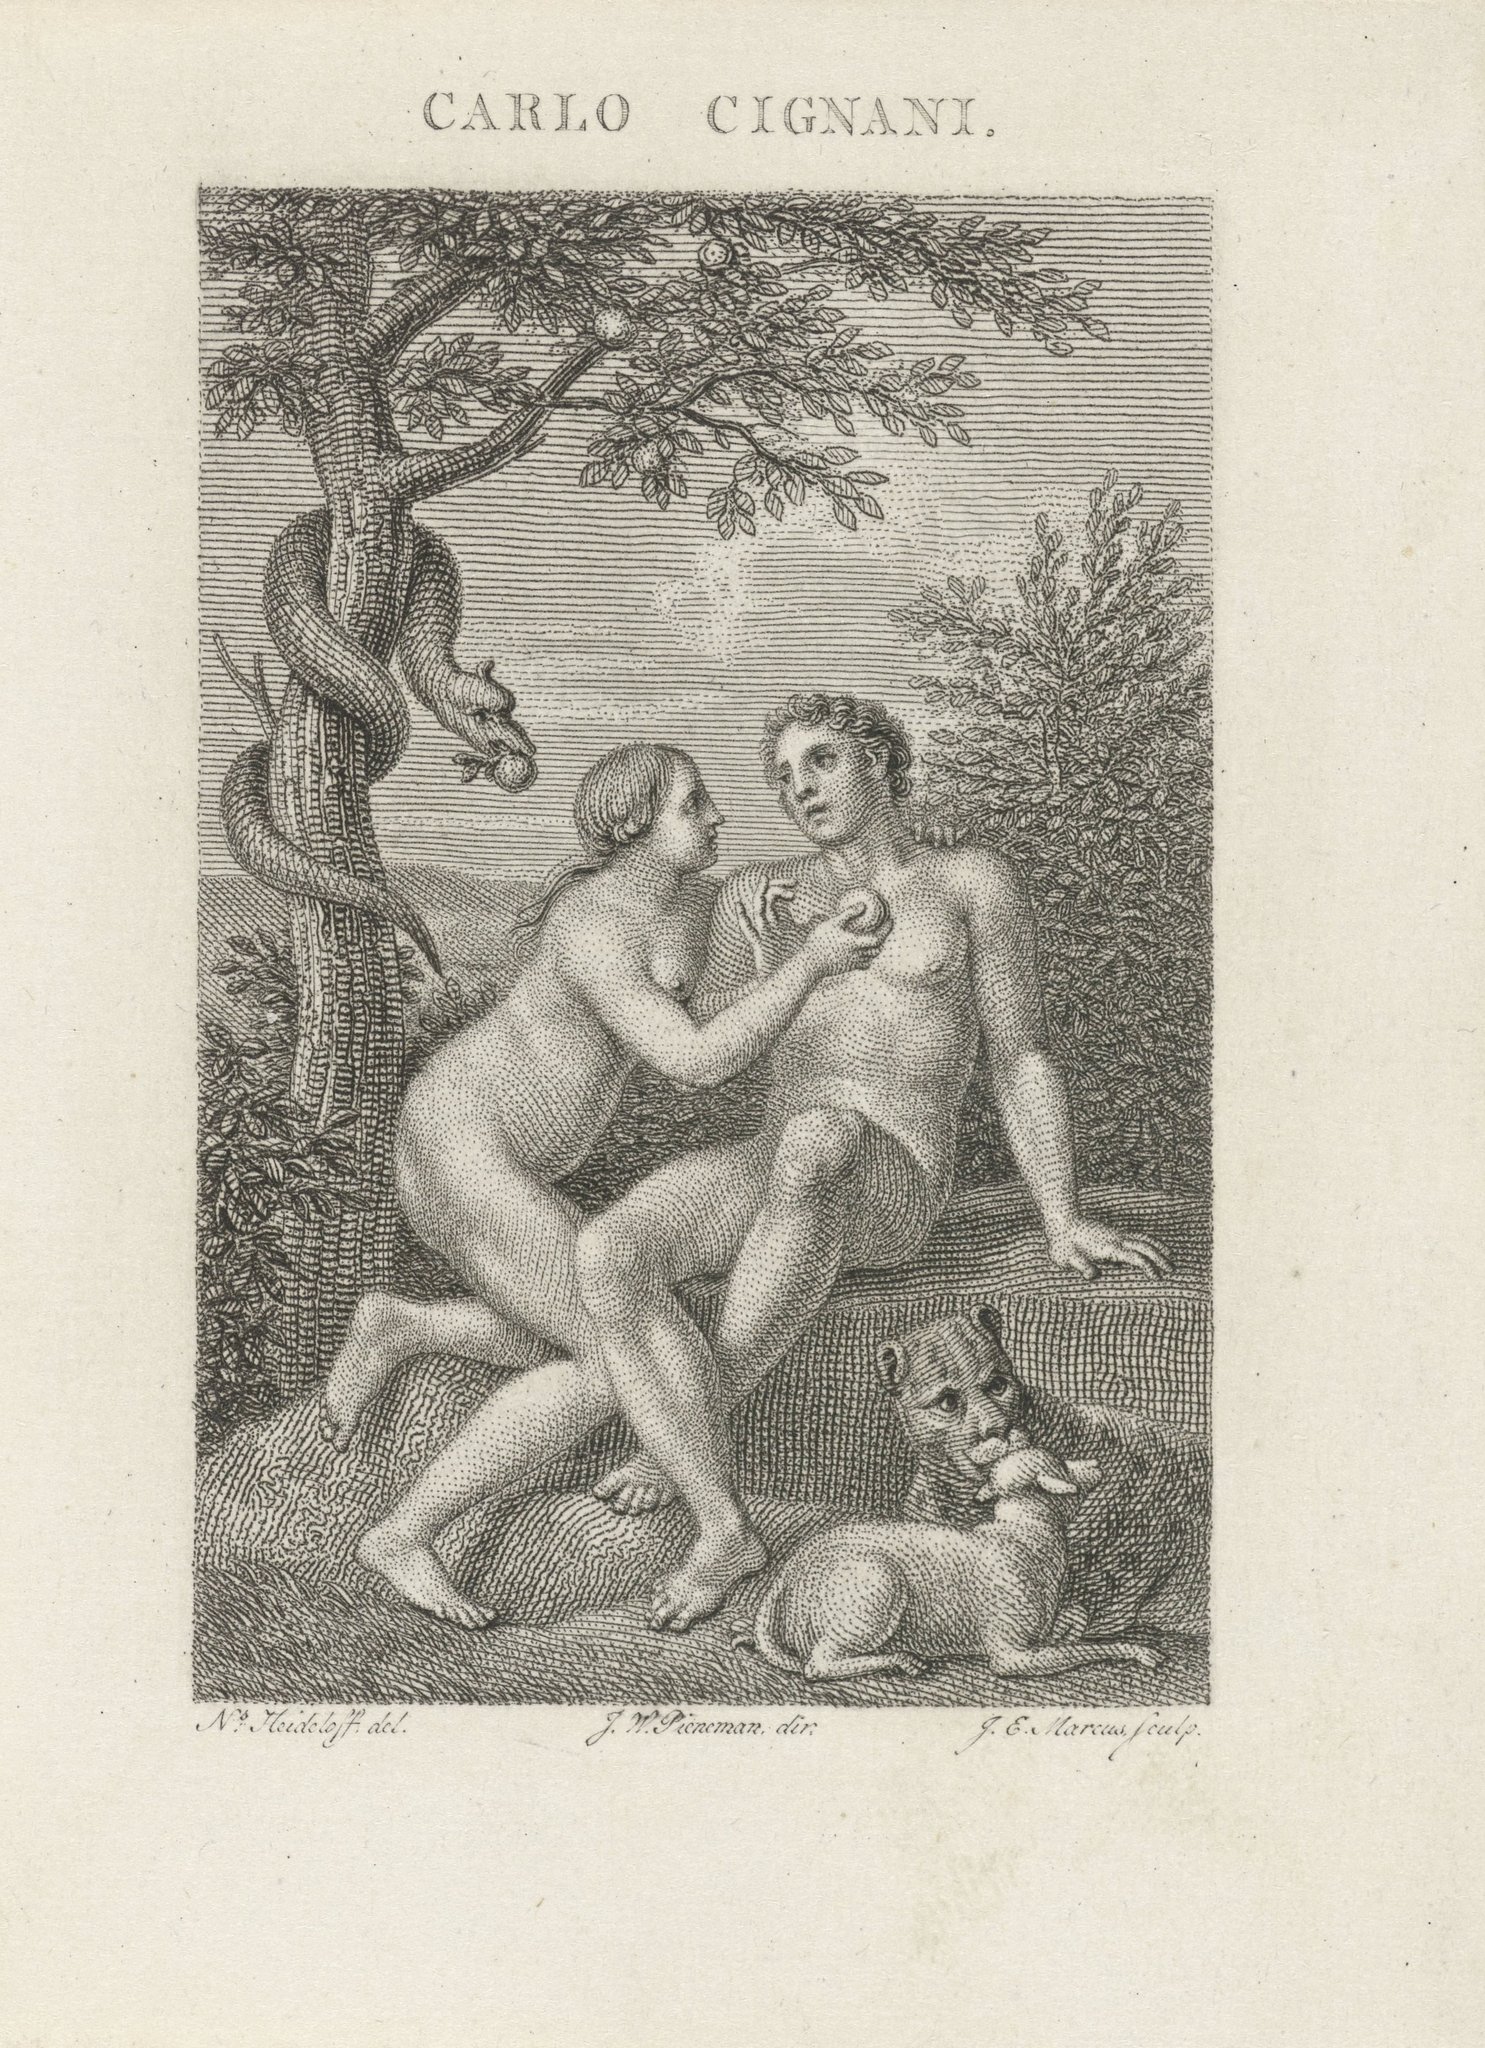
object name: print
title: De verzoeking van Adam en Eva in het paradijs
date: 1819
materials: paper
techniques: etching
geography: amsterdam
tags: eve offers the fruit to adam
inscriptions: inscription: ‘Ned. Muzen Alm. 1819’, collector's mark: Lugt 2228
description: Eva verleidt Adam tot het eten van de verboden vrucht. Links de slang met een appel in zijn bek, op de voorgrond speelt een roofdier met een lam.